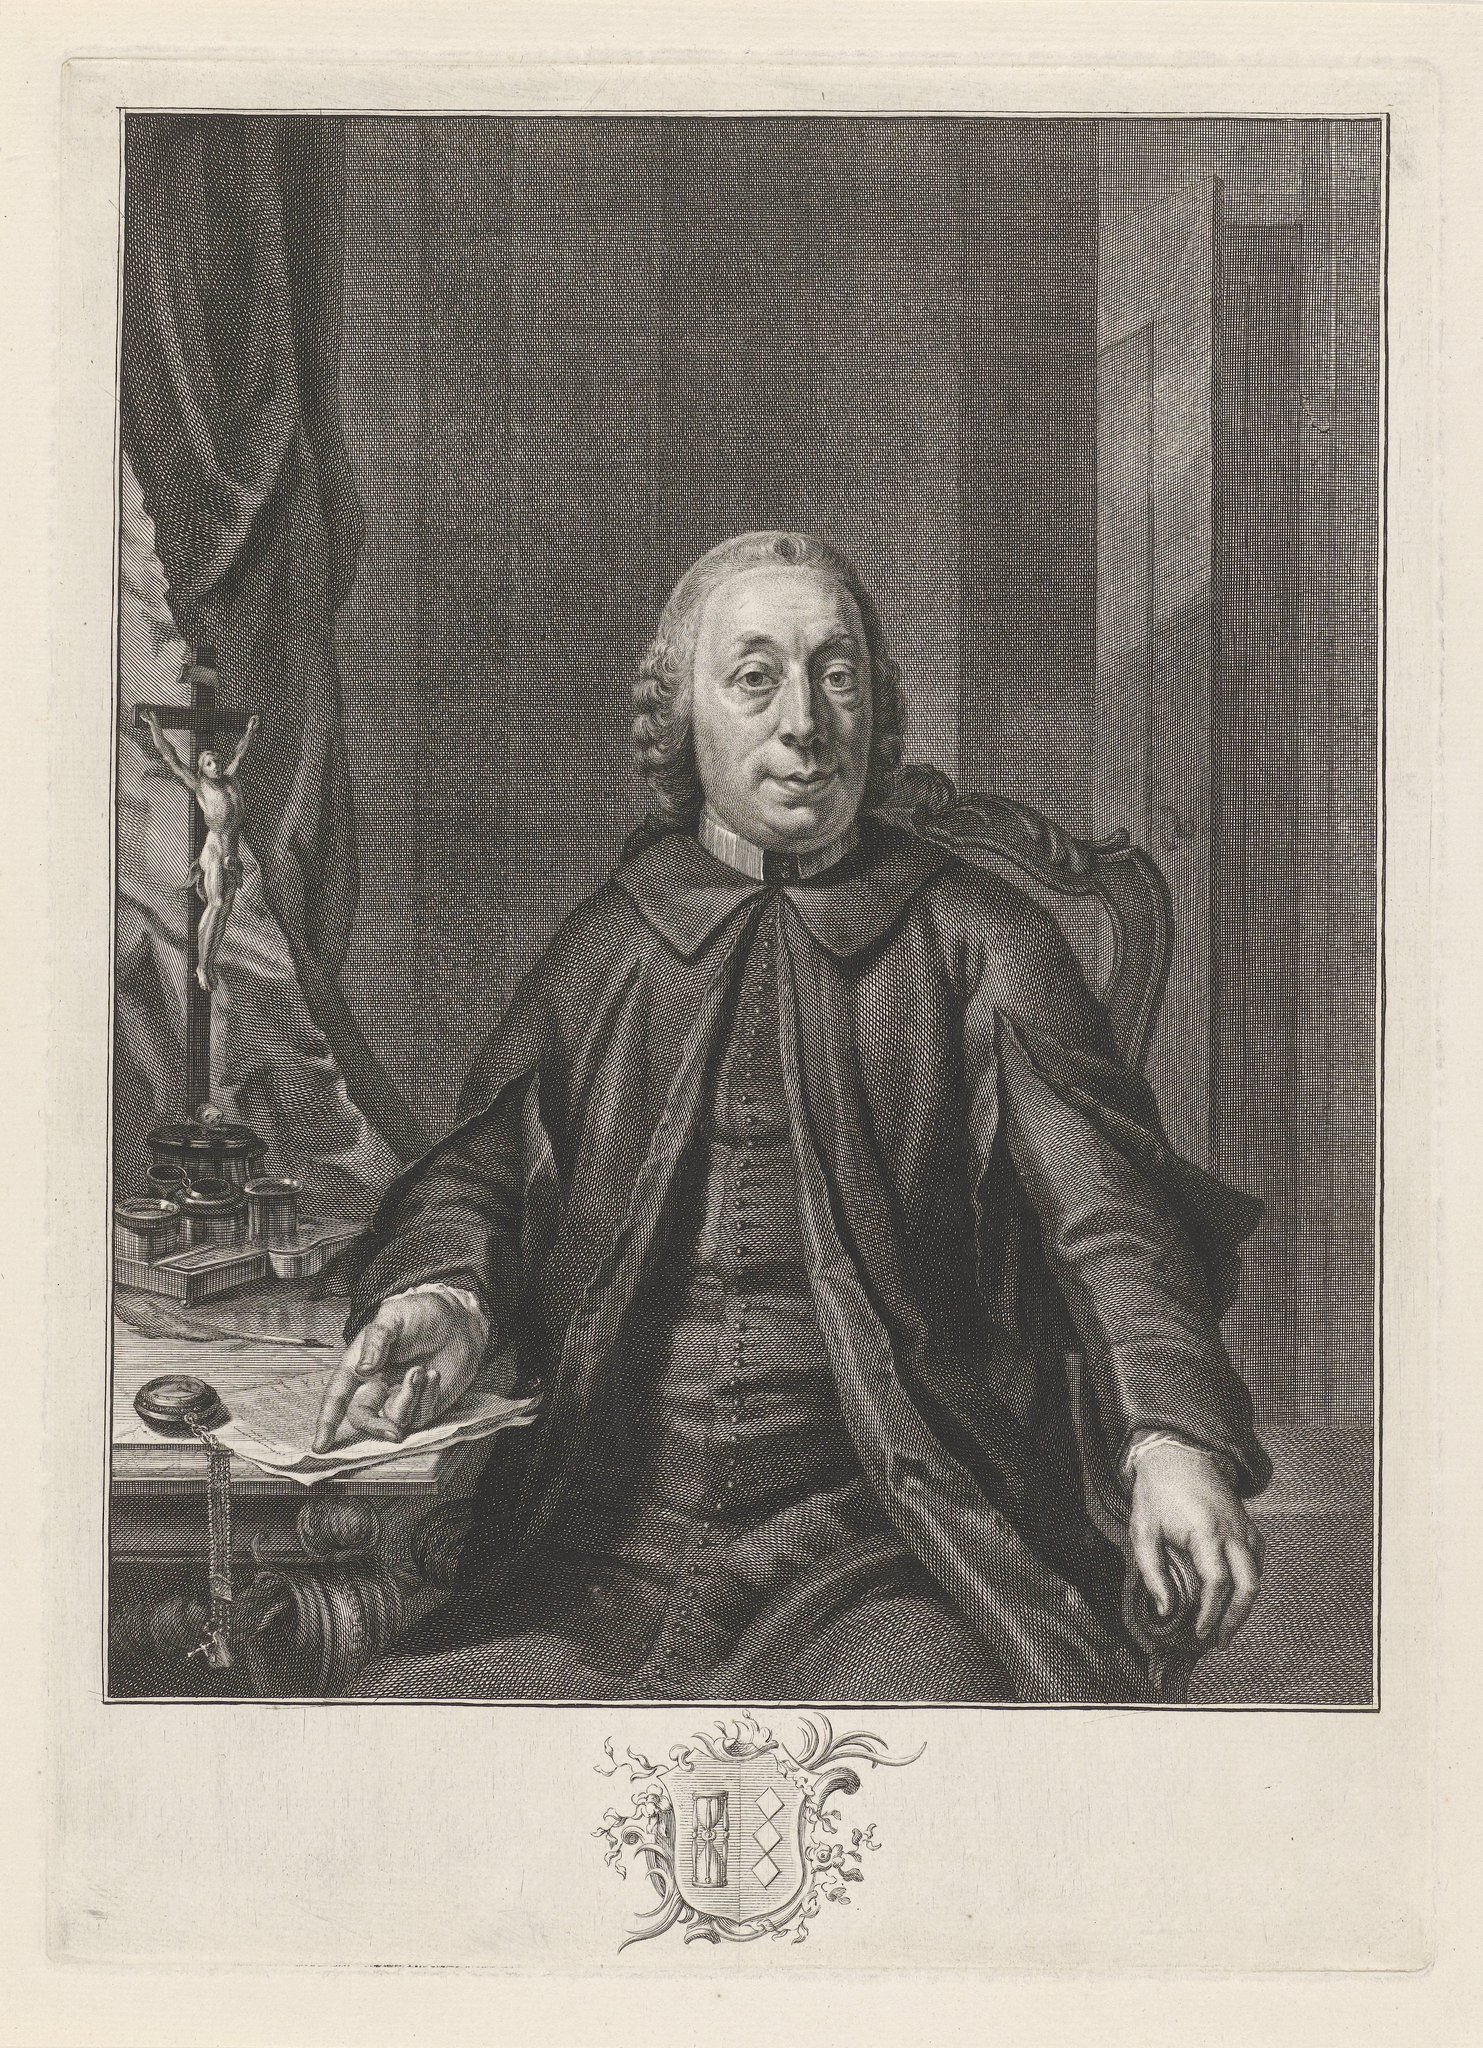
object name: print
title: Portret van Lucas Ahuys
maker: jacob houbraken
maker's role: draughtsman, print maker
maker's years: 1698-1780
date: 1732-1736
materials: paper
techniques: engraving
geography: amsterdam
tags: ink-well, crucifix ~ personal devotion, watch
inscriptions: collector's mark: Lugt 2228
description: Kniestuk van Lucas Ahuys, zittend aan een tafel waarop een crucifix en schrijfgerei. Onder het portret een wapen.